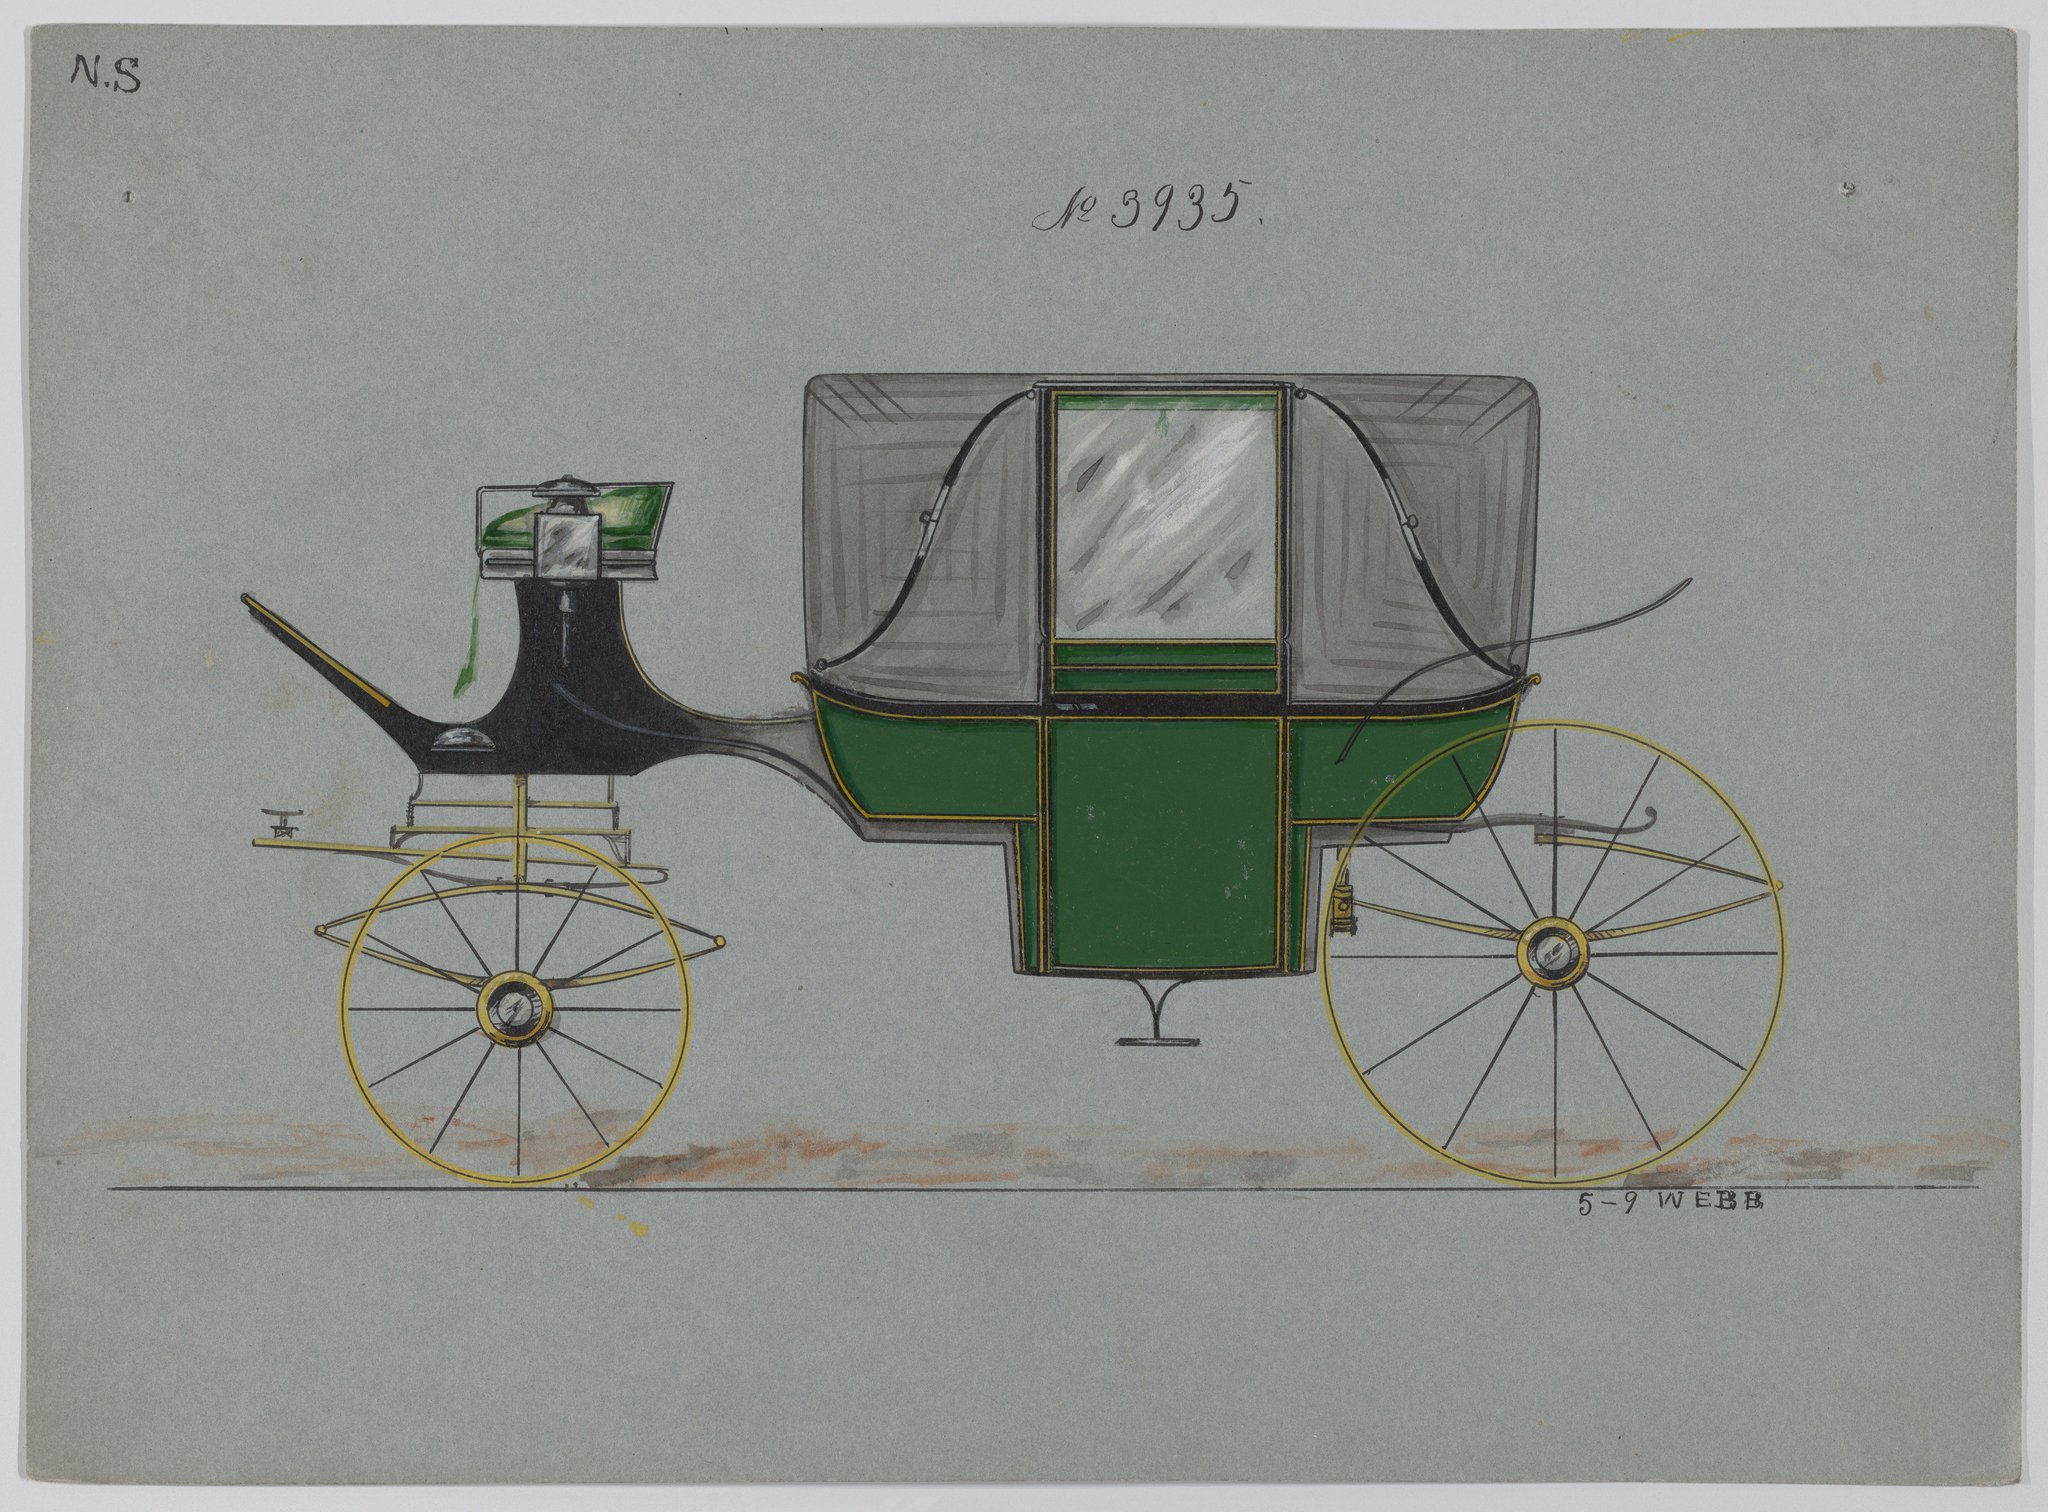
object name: drawing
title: Design for Landau, No. 3935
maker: brewster & co.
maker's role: manufacturer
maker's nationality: american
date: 1884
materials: gouache, gum arabic, ink, watercolor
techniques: pen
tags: carriages